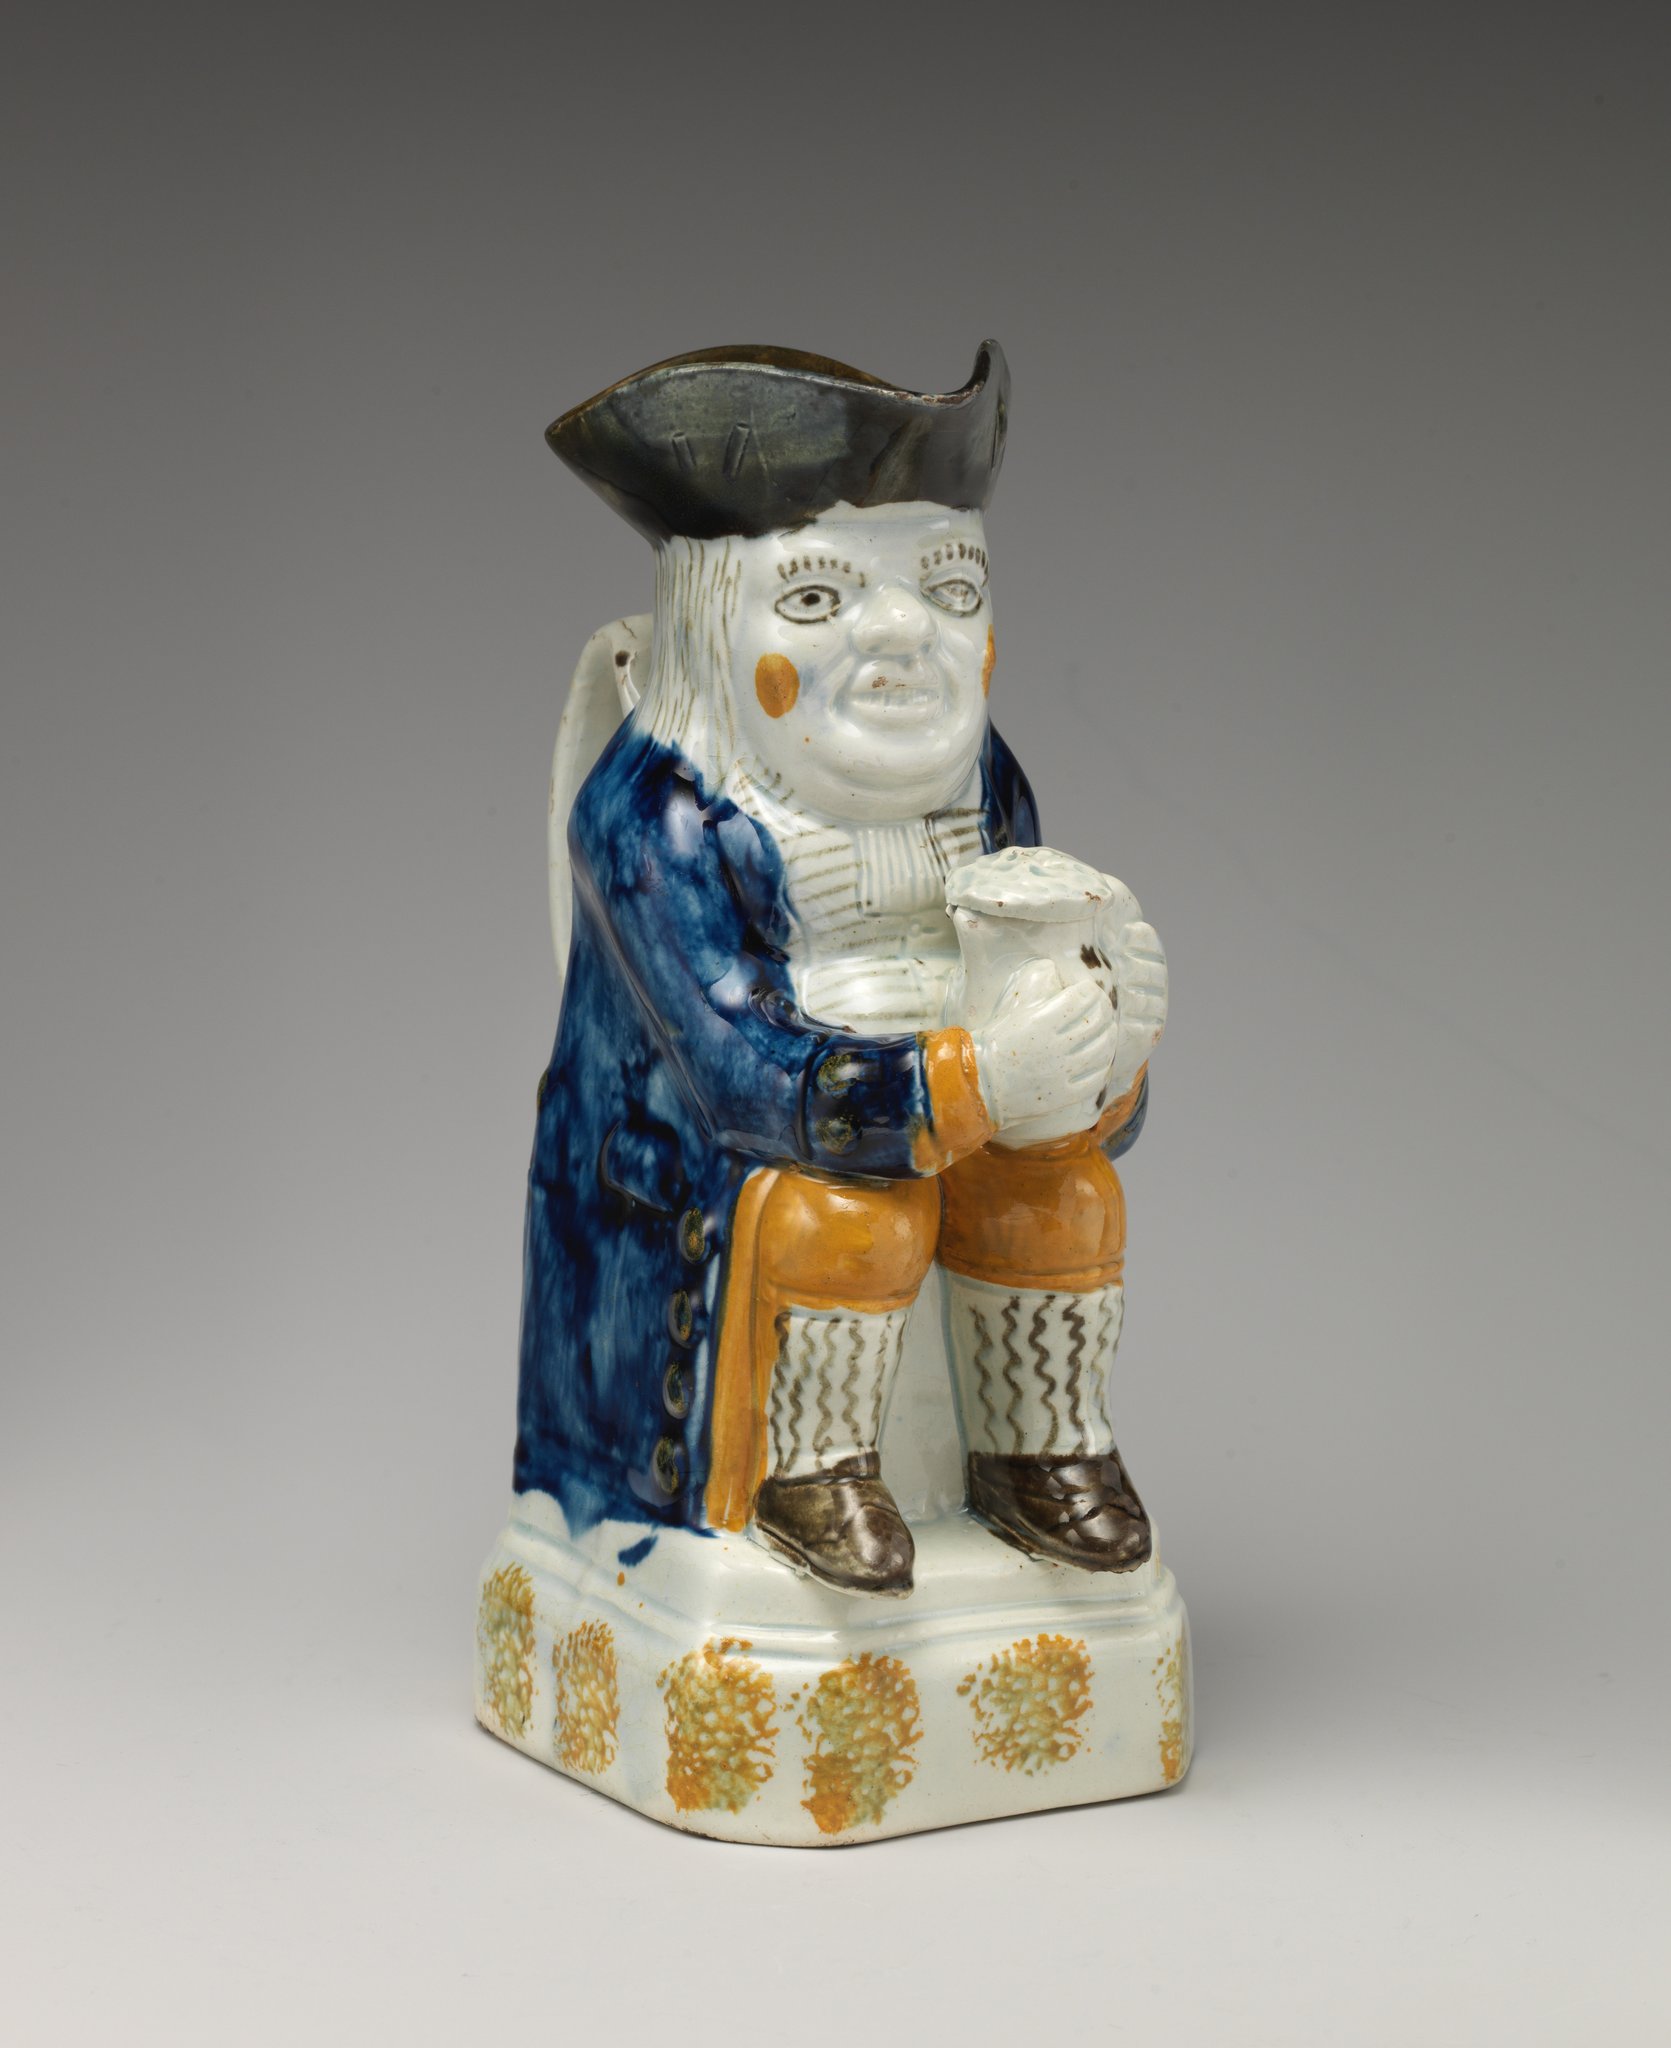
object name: toby jug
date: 1701-1900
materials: earthenware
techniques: glazing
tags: men